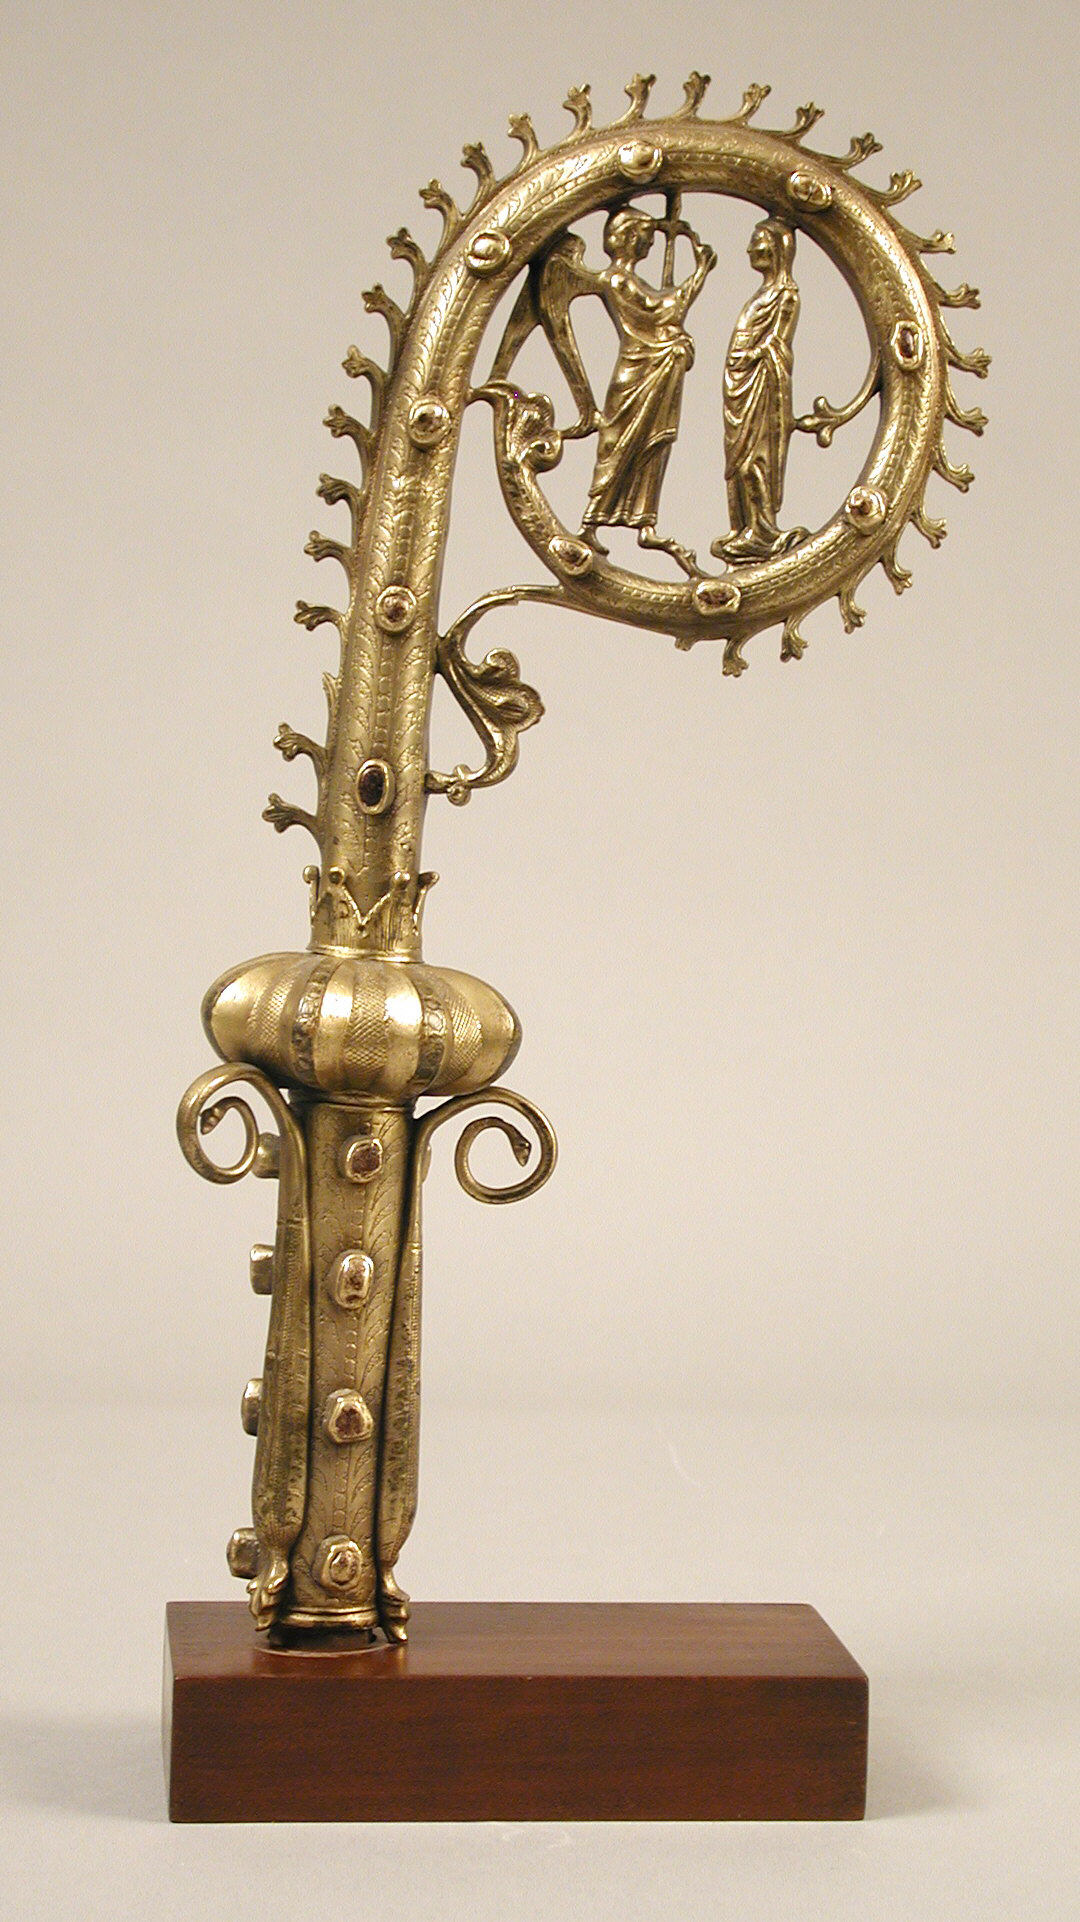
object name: crozier head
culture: french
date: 1901-1933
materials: gilt copper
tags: human figures,angels